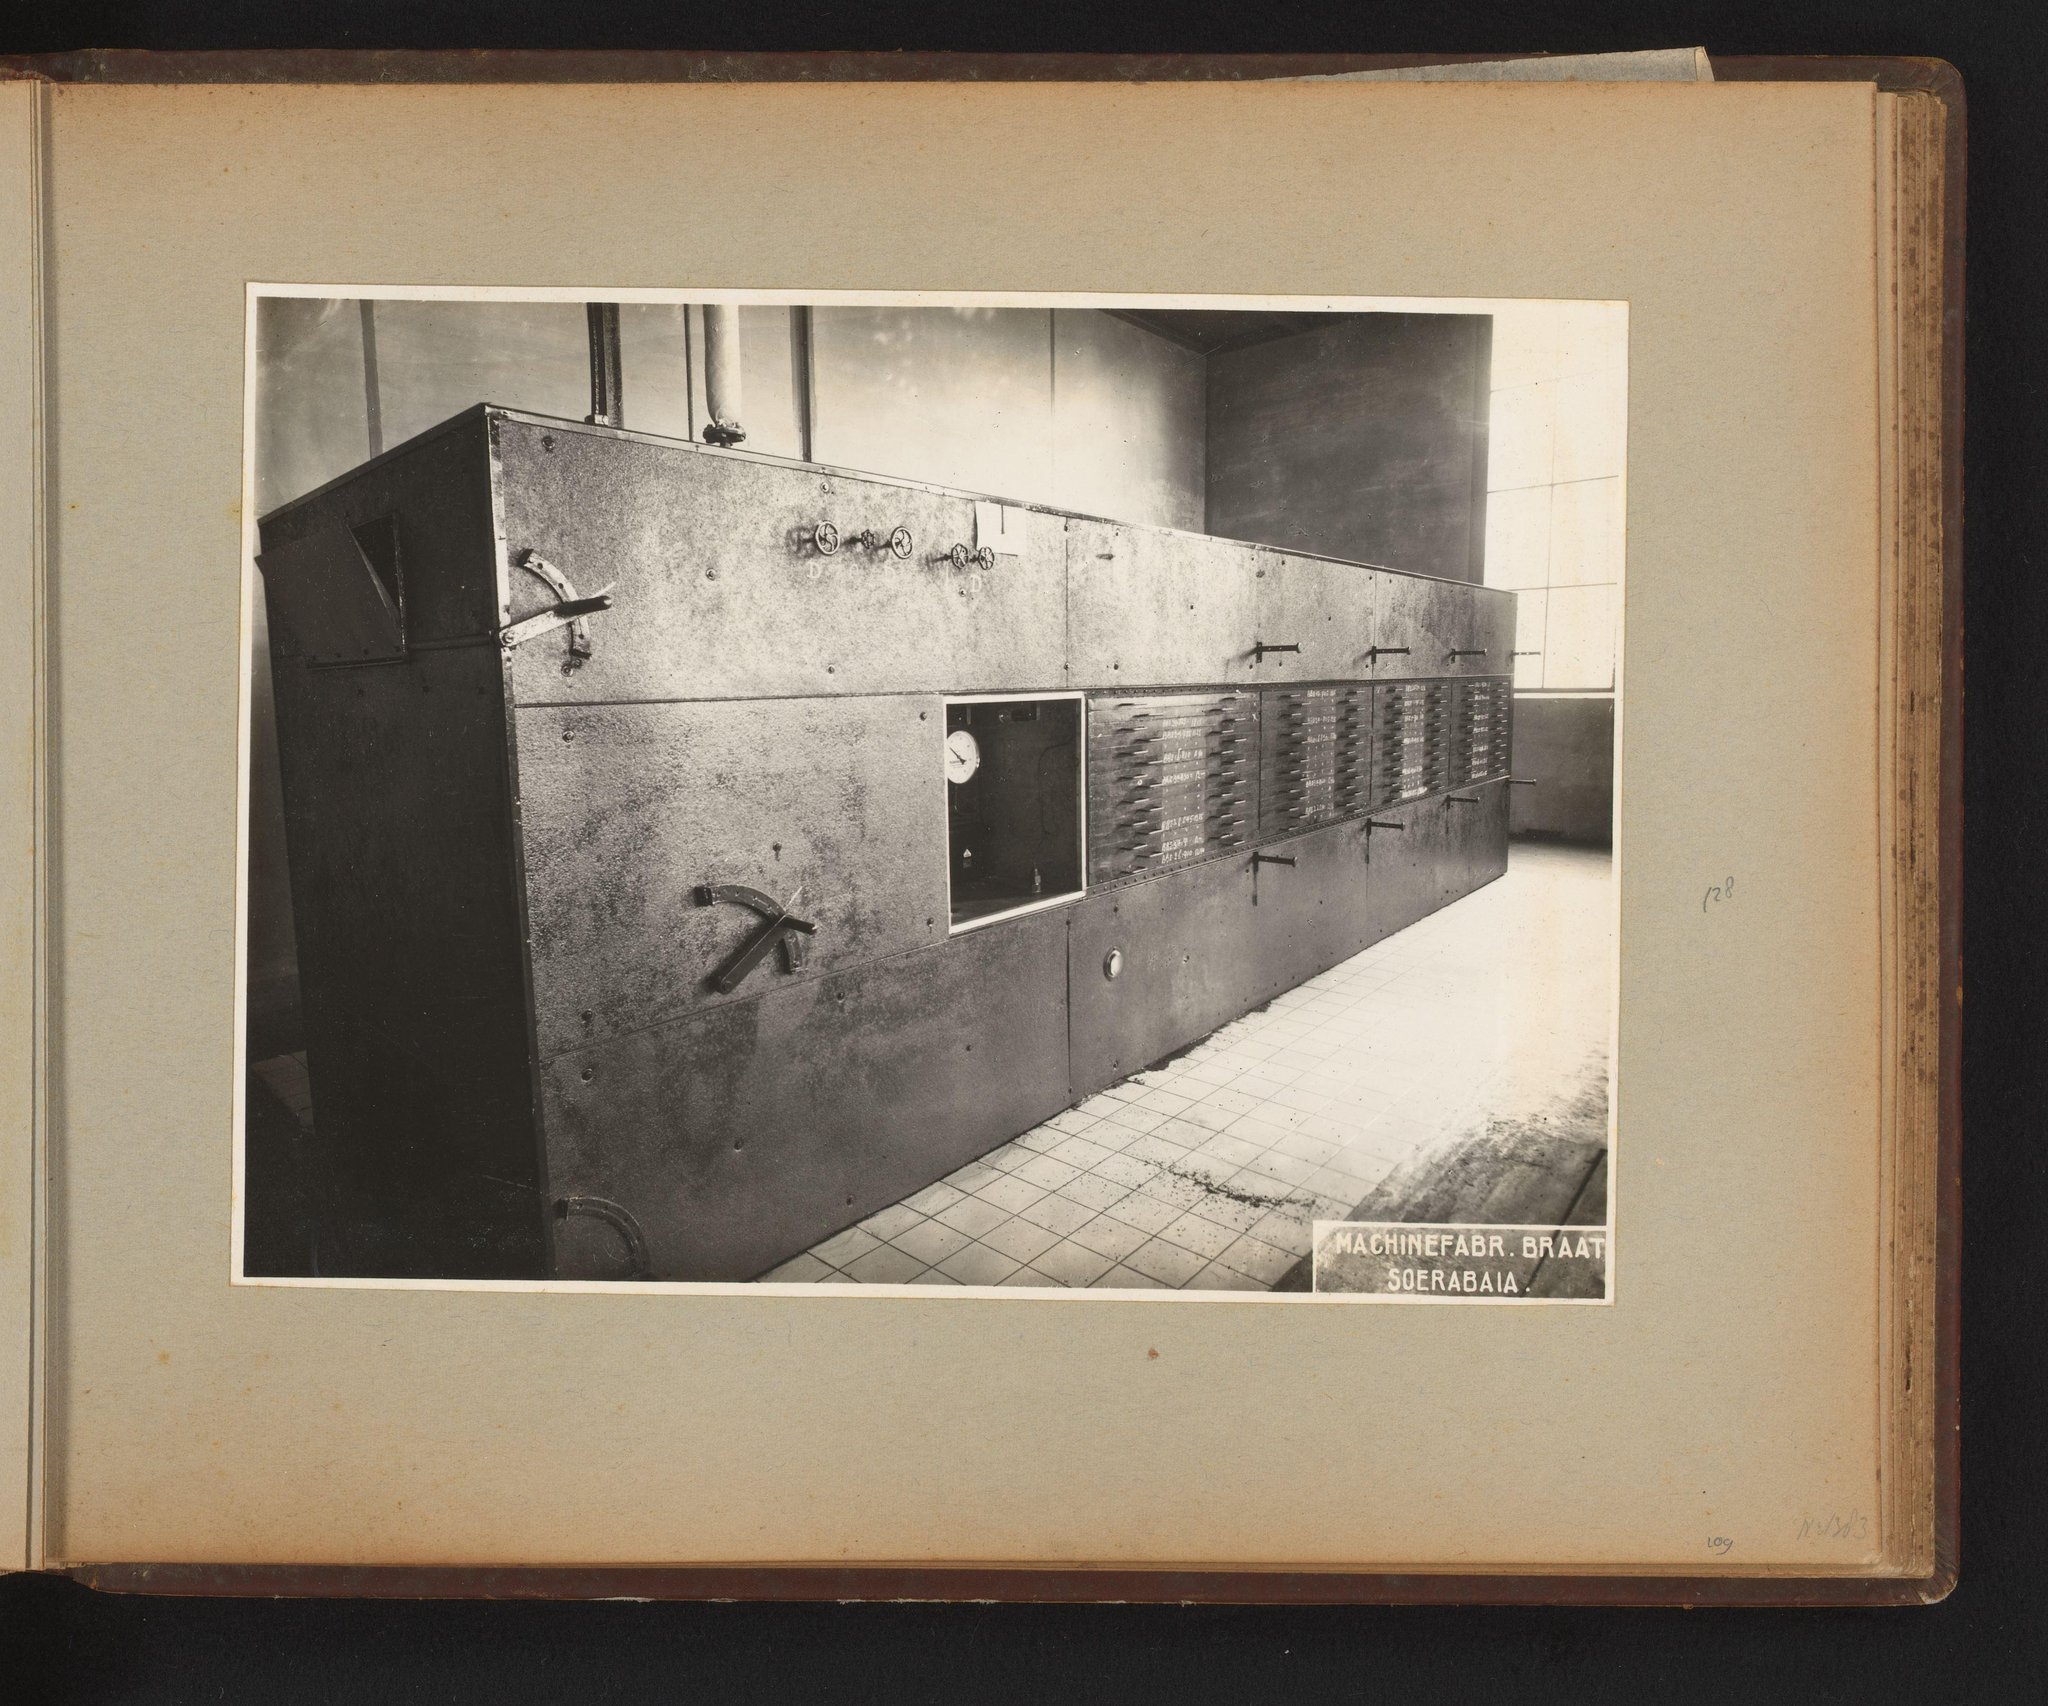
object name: photograph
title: Installatie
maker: Anonymous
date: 1931-1937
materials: cardboard, photographic support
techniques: gelatin silver print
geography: surabaya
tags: factory-interior, machine shop, machines; parts of machines; tools and appliances, java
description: Albumblad met een foto van een machine of installatie in een fabriekshal. Onderdeel van een fotoalbum met foto's van machines en constructies van de N.V. Machinefabriek Braat te Soerabaja, Soekaboemi en Tegal uit de periode 1931-1937.